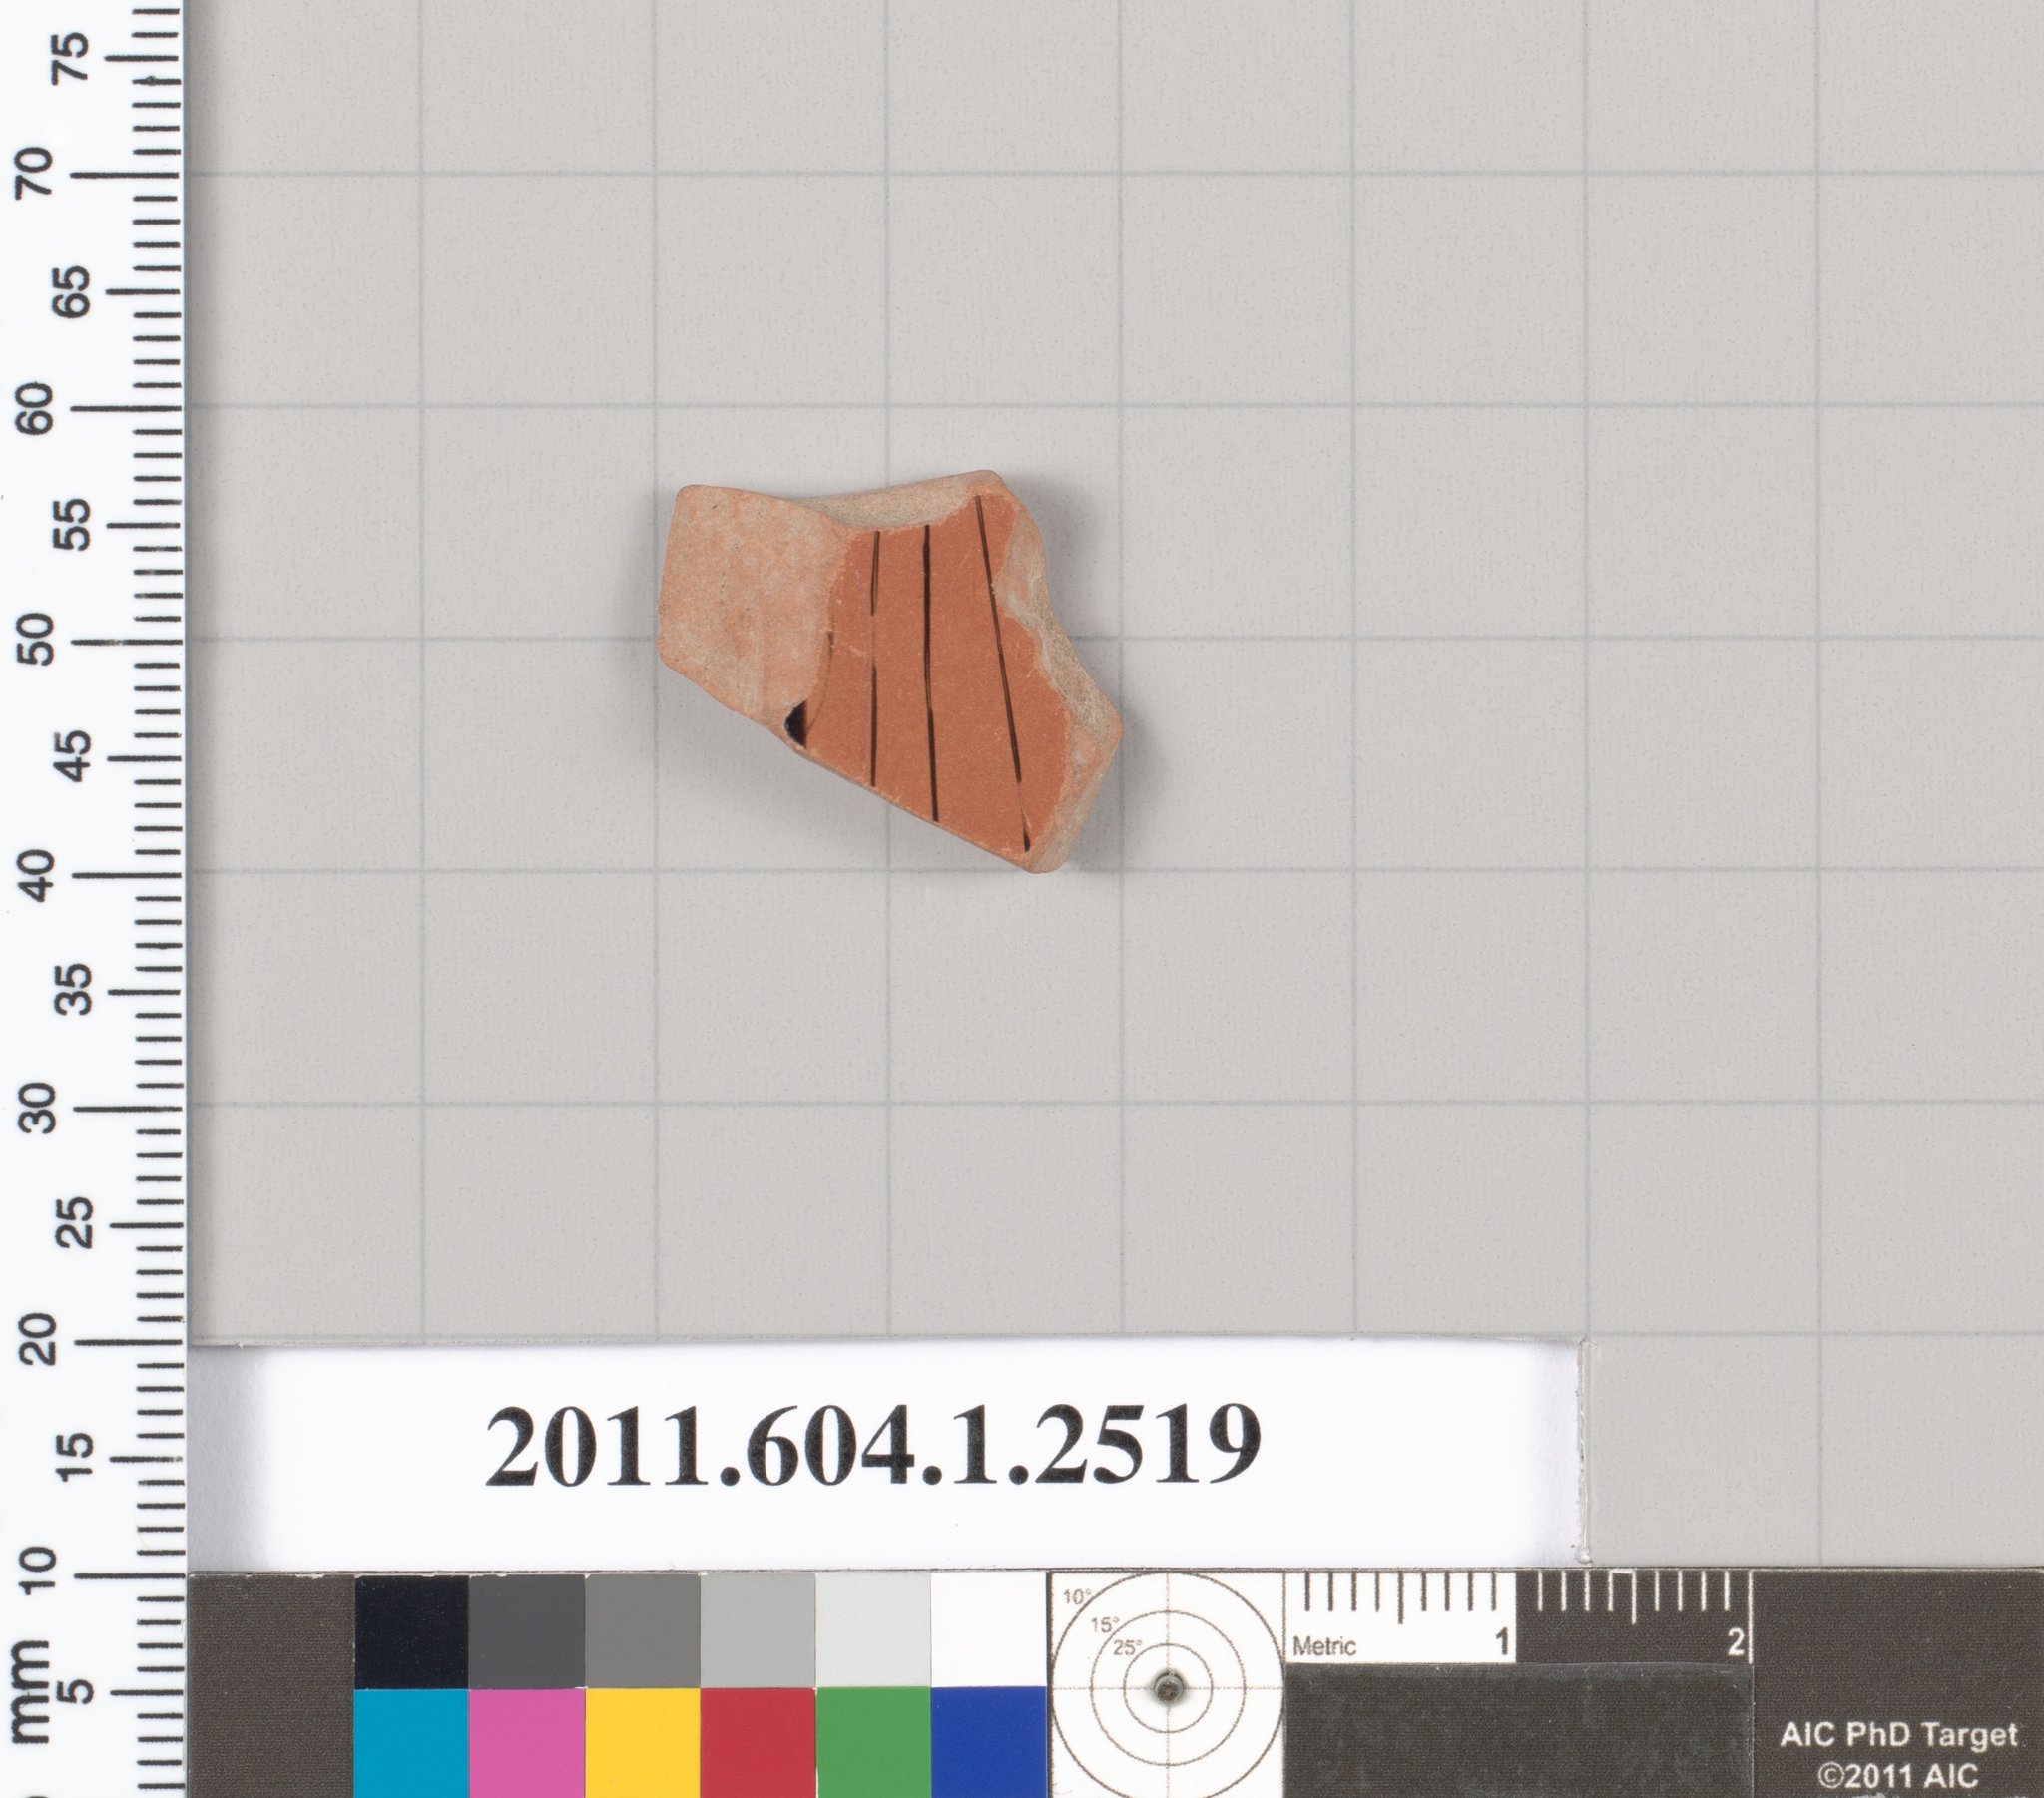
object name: kylix fragment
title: Terracotta fragment of a kylix (drinking cup)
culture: greek, attic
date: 475-451 BCE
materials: terracotta